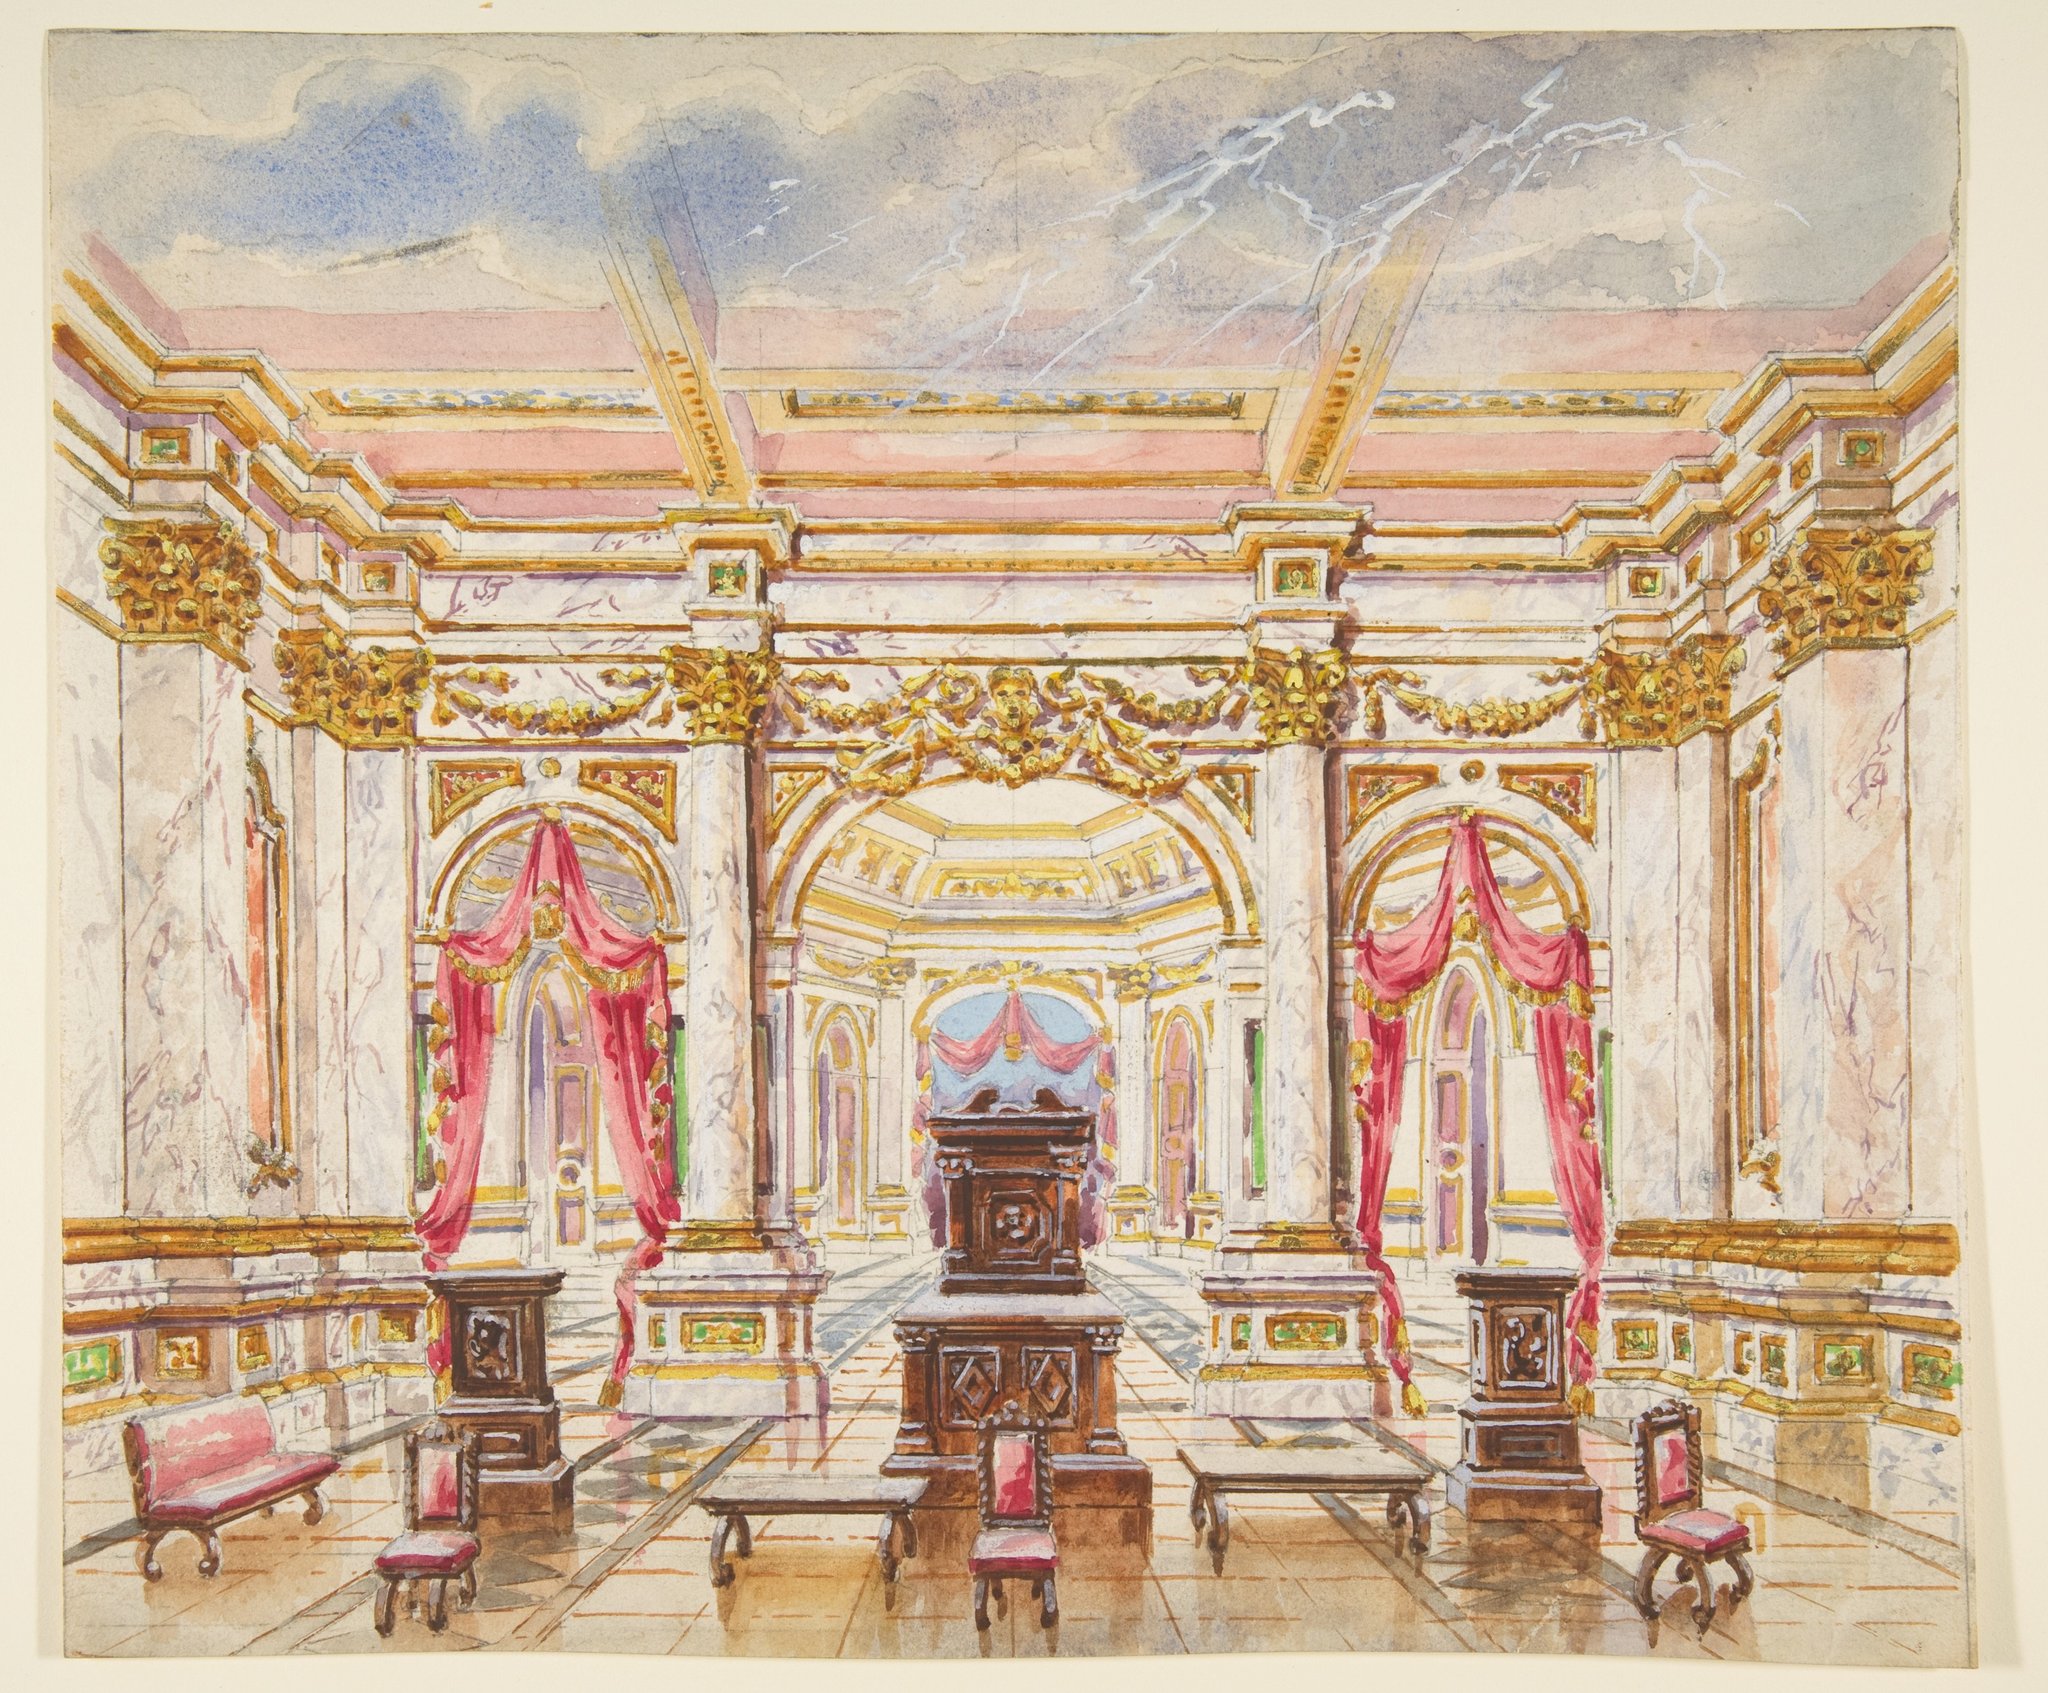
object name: drawing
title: Interior with Marble and Gilt Decor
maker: anonymous, french, 19th century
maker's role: artist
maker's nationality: french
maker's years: 1800-1900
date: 1801-1900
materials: watercolor, paper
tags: interiors,chairs,tables